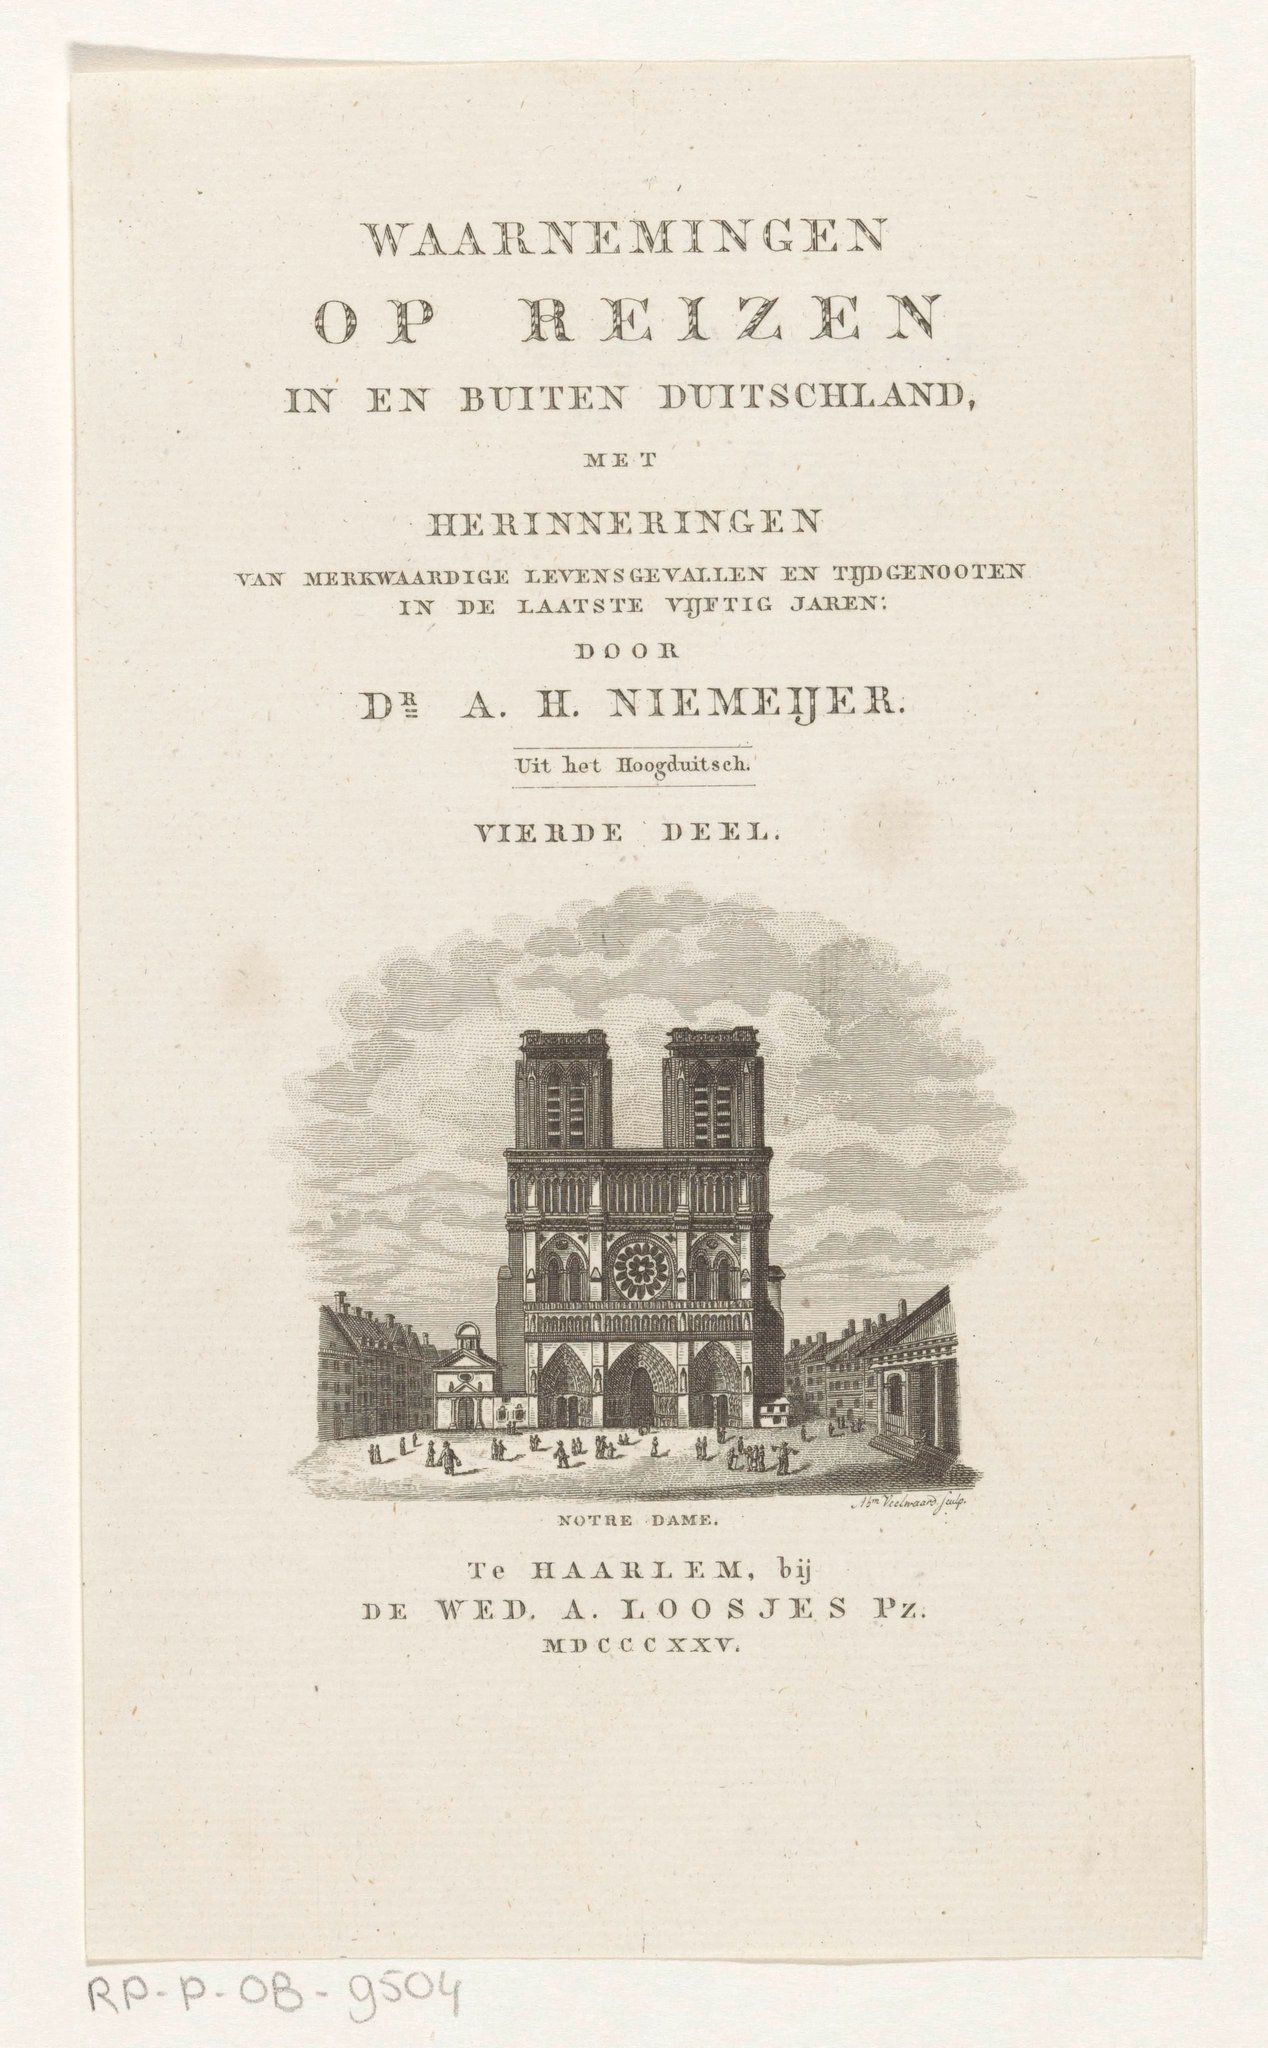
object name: print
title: Titelpagina voor: A.H. Niemeyer, Waarnemingen op reizen in en buiten Duitschland, 1825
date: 1825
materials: paper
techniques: engraving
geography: haarlem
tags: church (exterior)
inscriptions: collector's mark: Lugt 2228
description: Titelpagina voor: Niemeyer, A.H. Waarnemingen op Reizen in en buiten Deitschland met herinneringen, vierde deel. Haarlem: Loosjes Pz., weduwe Adriaan, 1825.